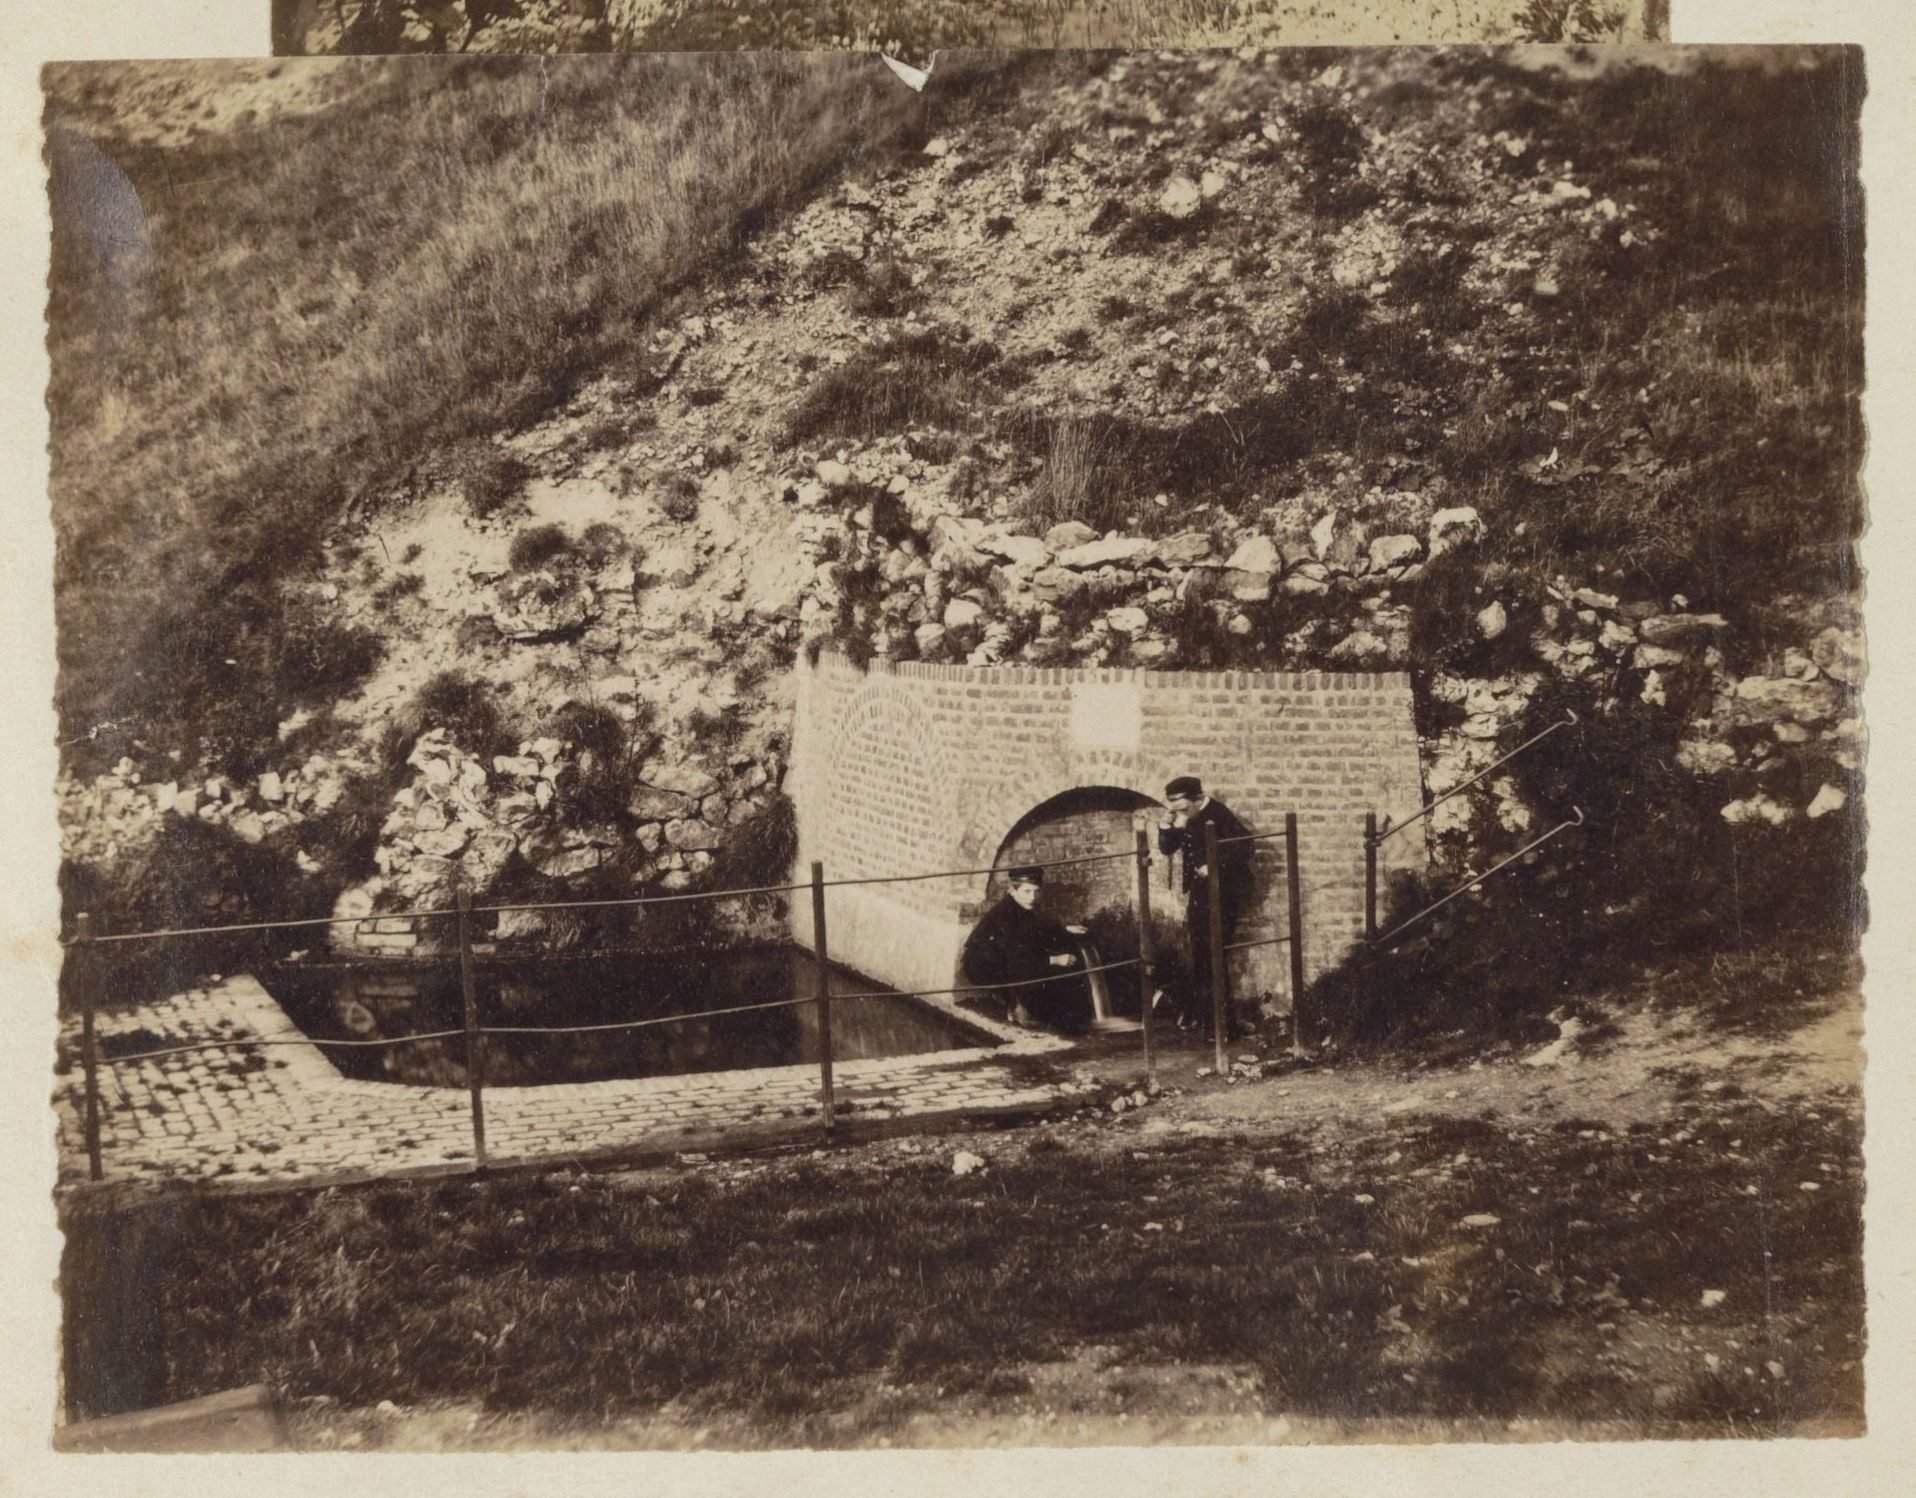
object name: photograph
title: Twee jongens bij een wasplaats in Frankrijk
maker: Anonymous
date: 1809-1883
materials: photographic support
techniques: albumen print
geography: france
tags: public wash house, france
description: Onderdeel van Album van een Franse amateurfotograaf met opnames van familie, militairen, industrie, landschappen en bezienswaardigheden in Frankrijk.